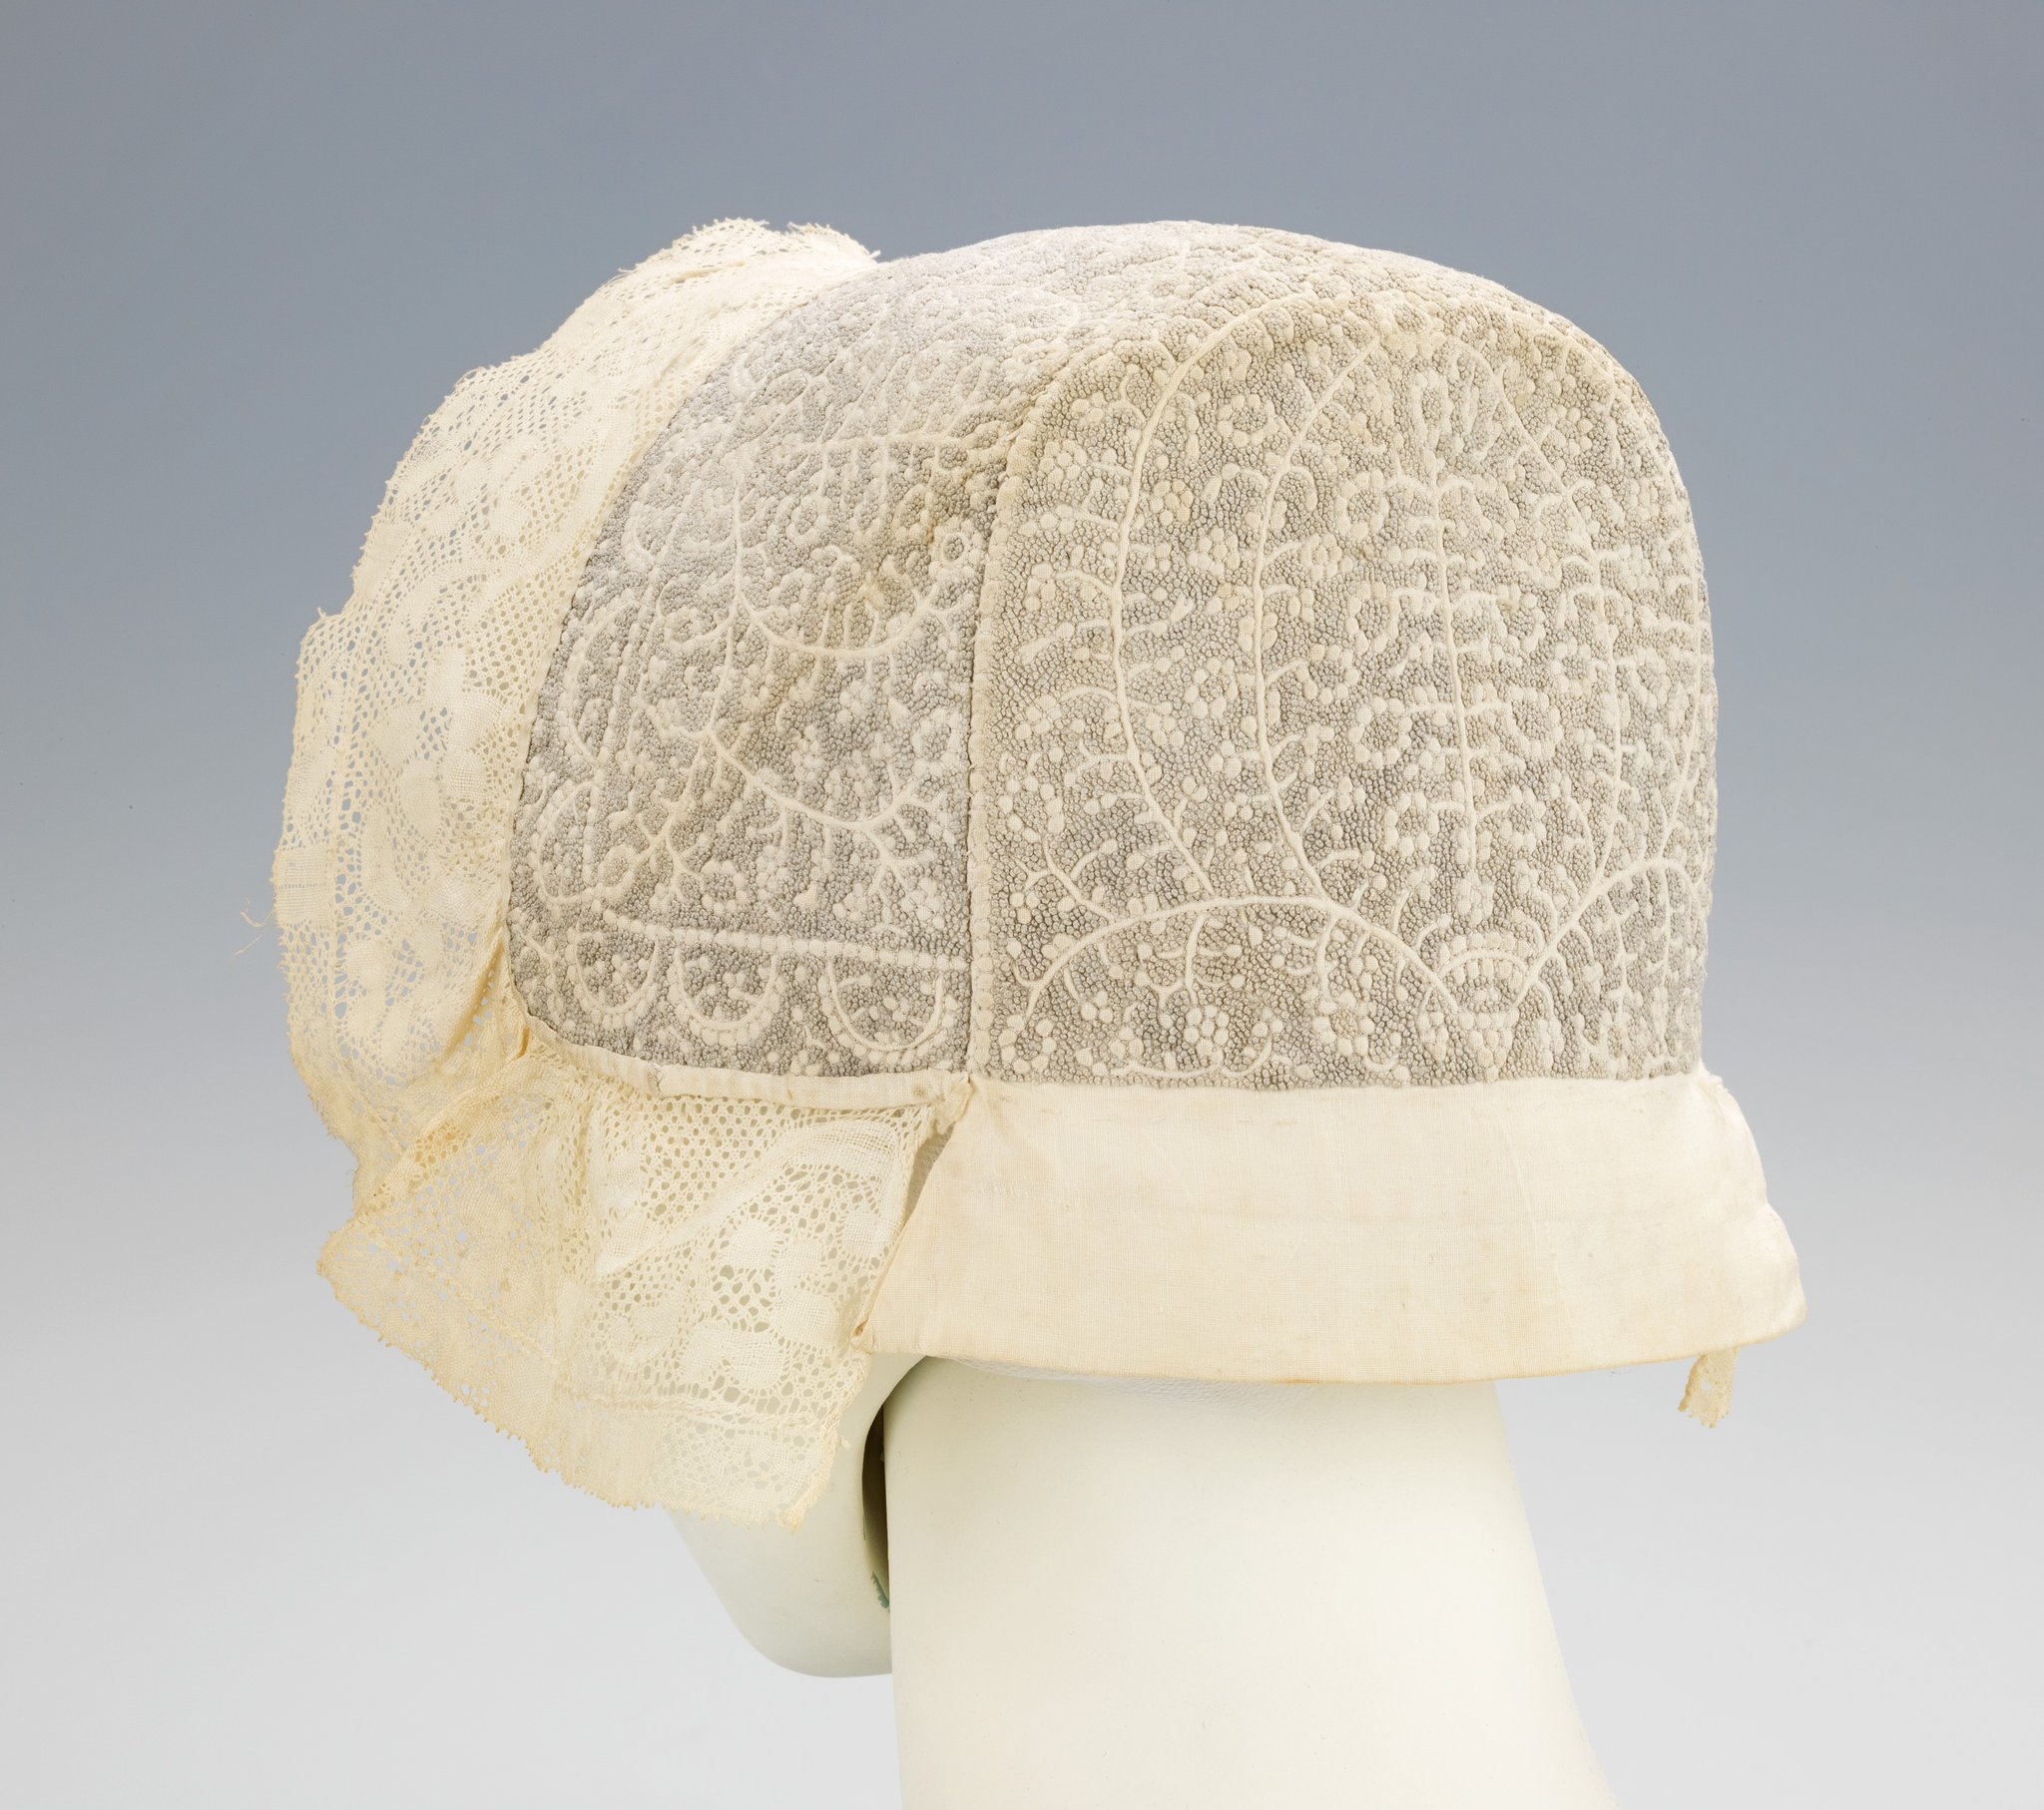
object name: cap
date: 1830-1850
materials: linen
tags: flowers